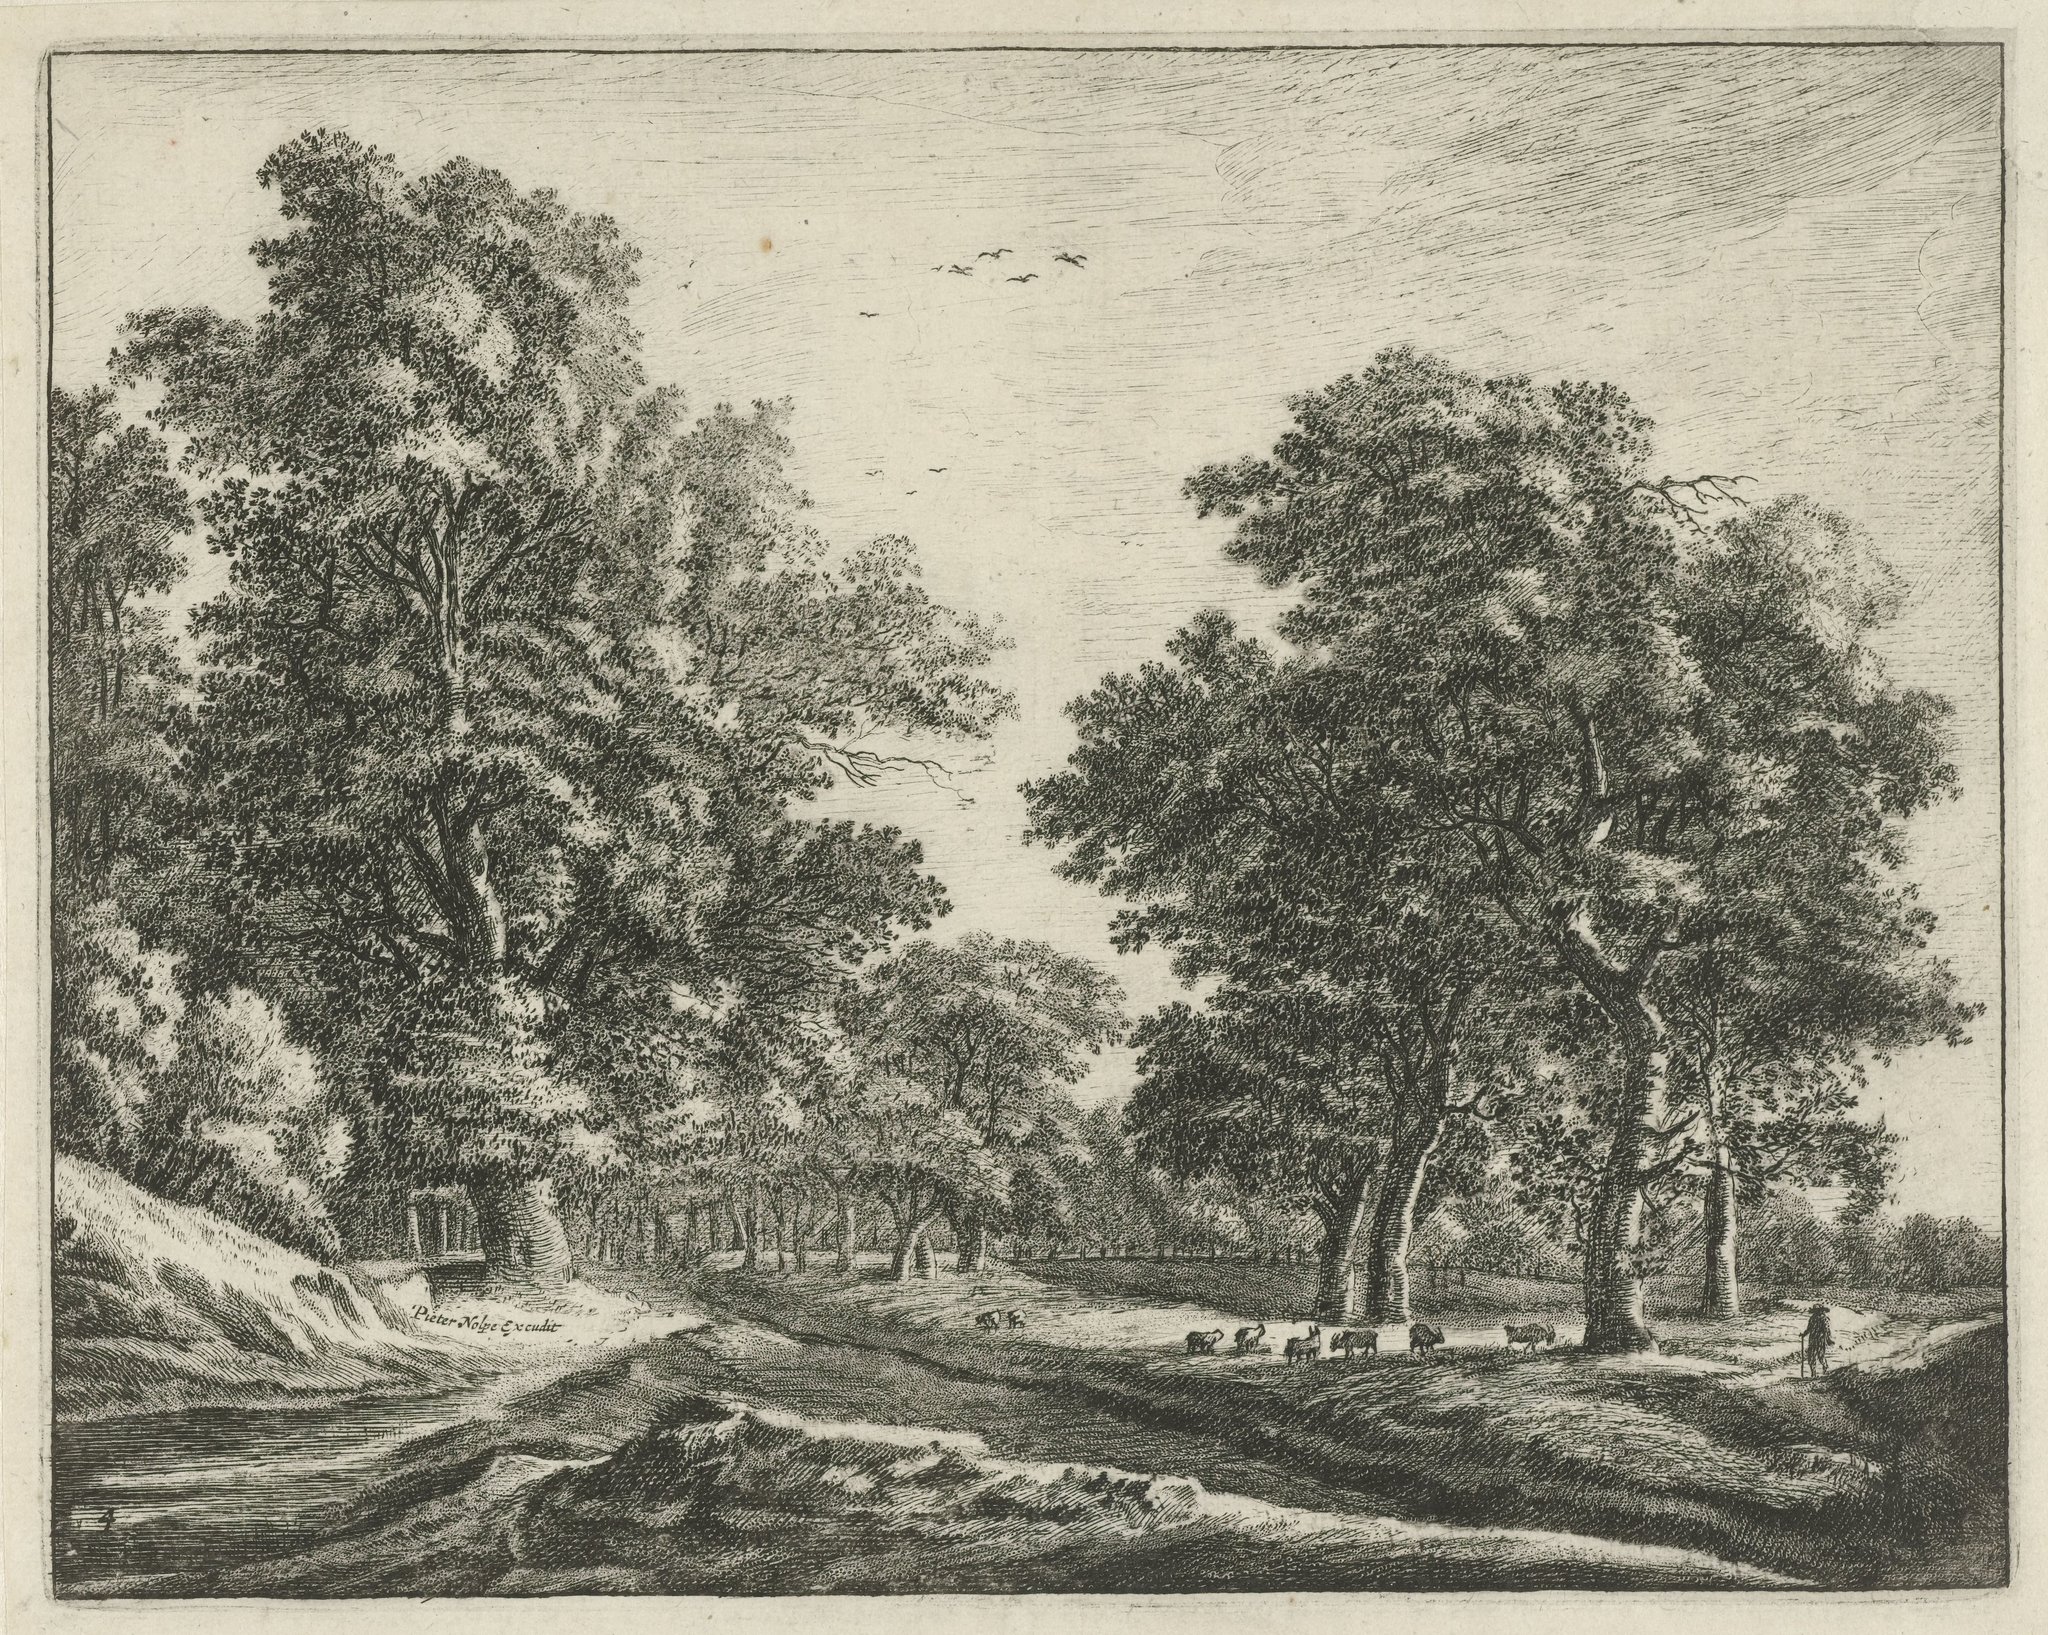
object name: print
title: Gezichten in het Haagse Bos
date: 1637-1652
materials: paper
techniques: etching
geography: amsterdam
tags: forest, wood, glade, 'lichtung im wald', forest path or lane, goat, 'en route', traveller under way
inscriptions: collector's mark: Lugt 240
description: Op een open plek in het Haagse Bos grazen enkele geiten. Langs de plek loopt een pad. Rechts een wandelaar.